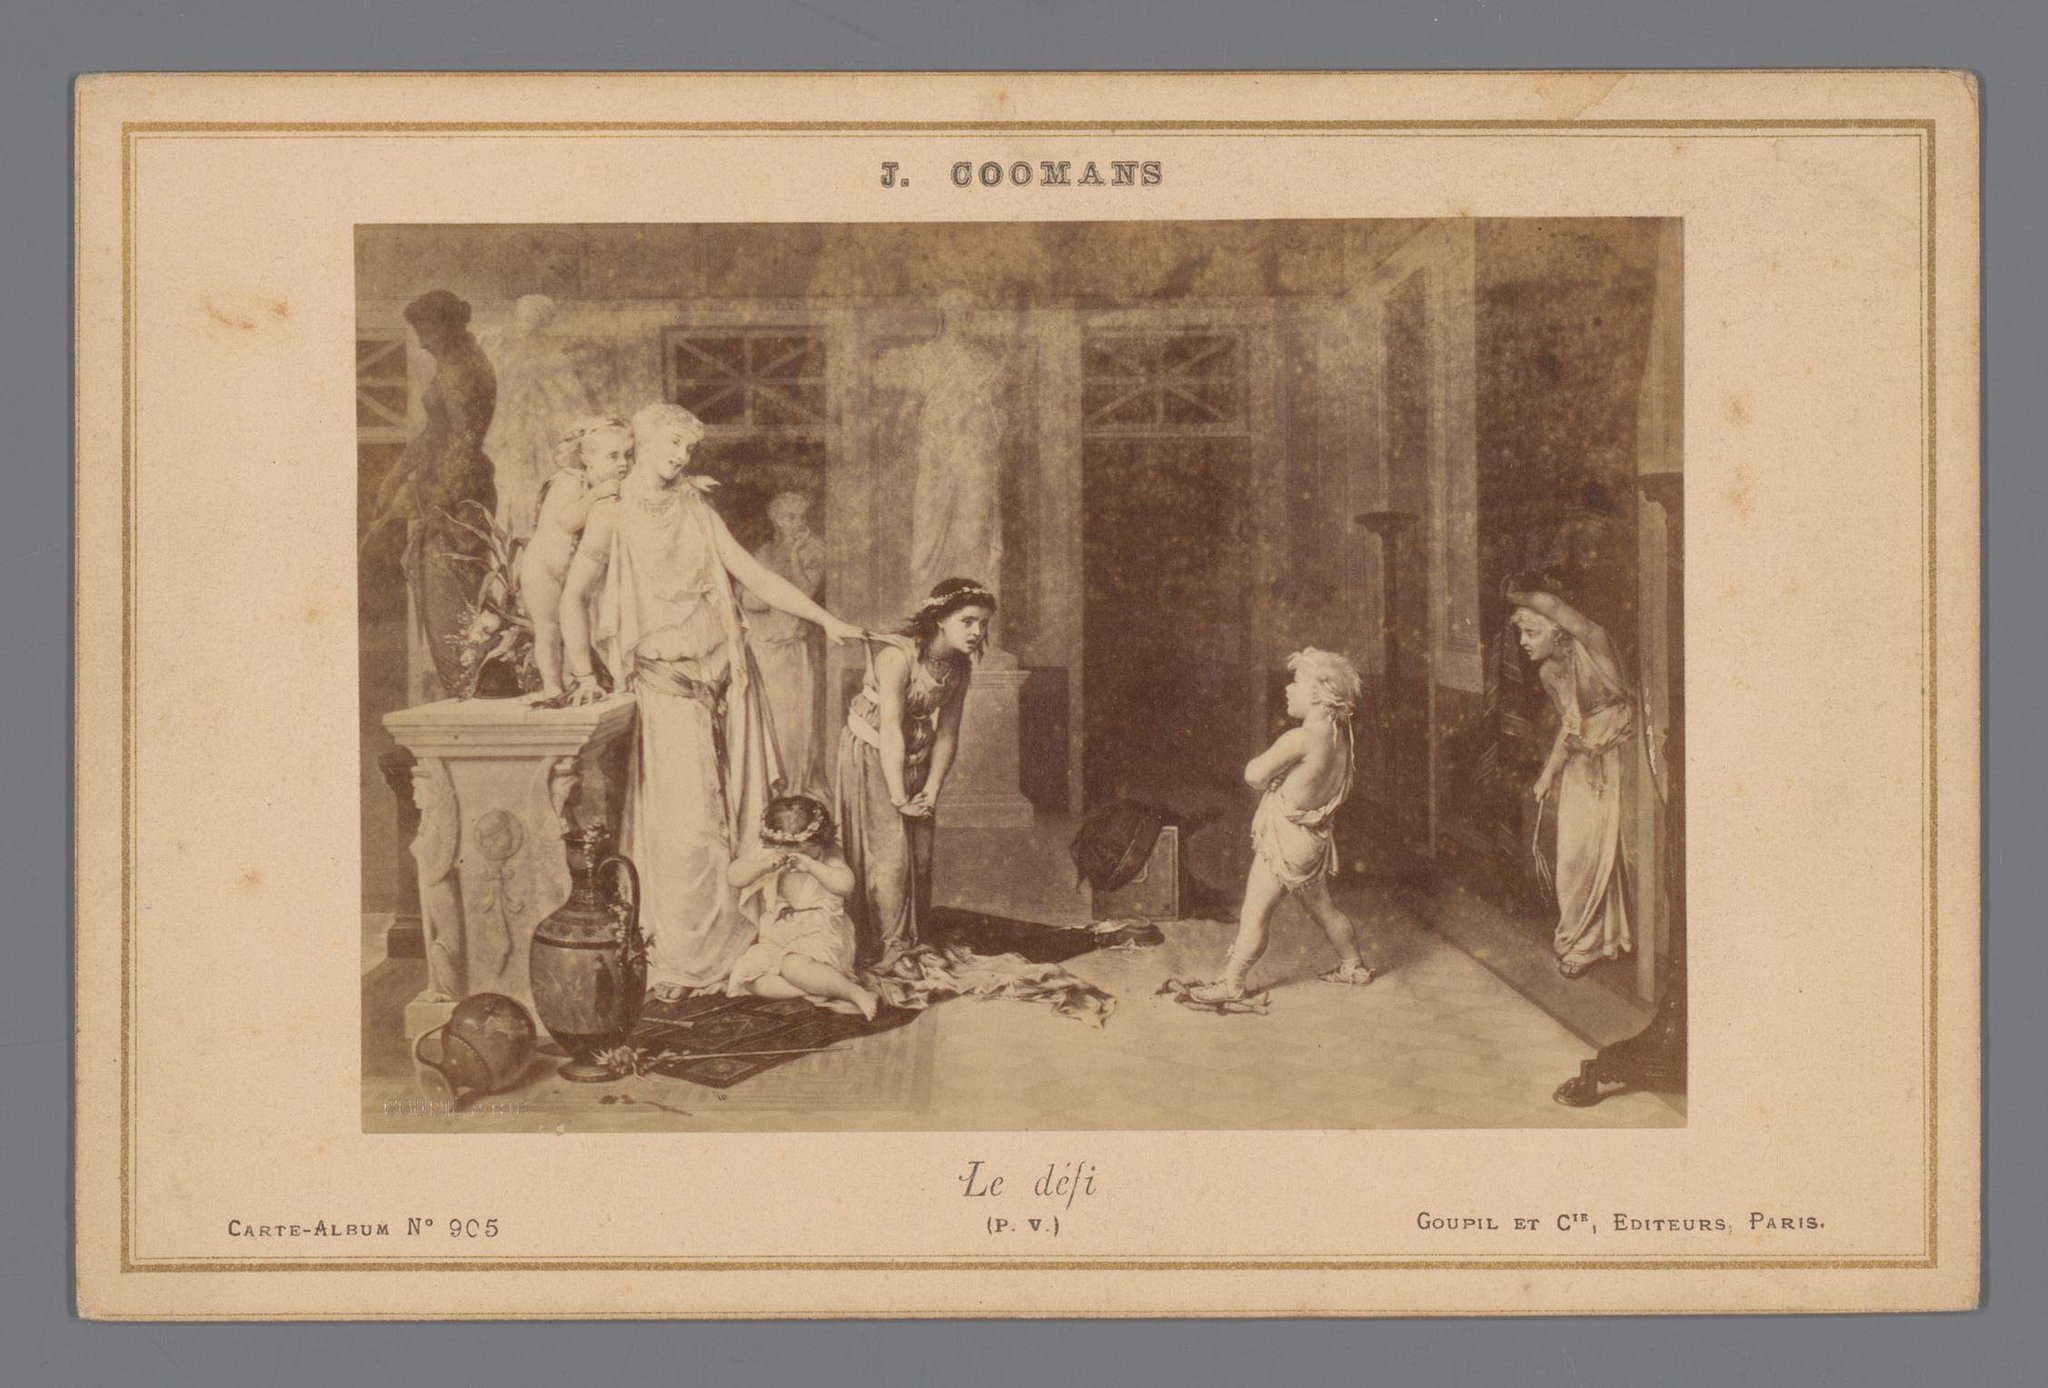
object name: photograph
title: Fotoreprodcutie van schilderij Le Défi van J. Coomans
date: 1870-1890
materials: cardboard, paper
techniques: albumen print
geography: paris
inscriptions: inscription: ‘Goupil et Cie. Editeurs, Paris.’, inscription: ‘Le Défi//(P.V.)’, inscription: ‘Carte-album No. 905’, inscription: ‘J. Coomans’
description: Fotoreprodcutie van schilderij Le Défi van J. Coomans.